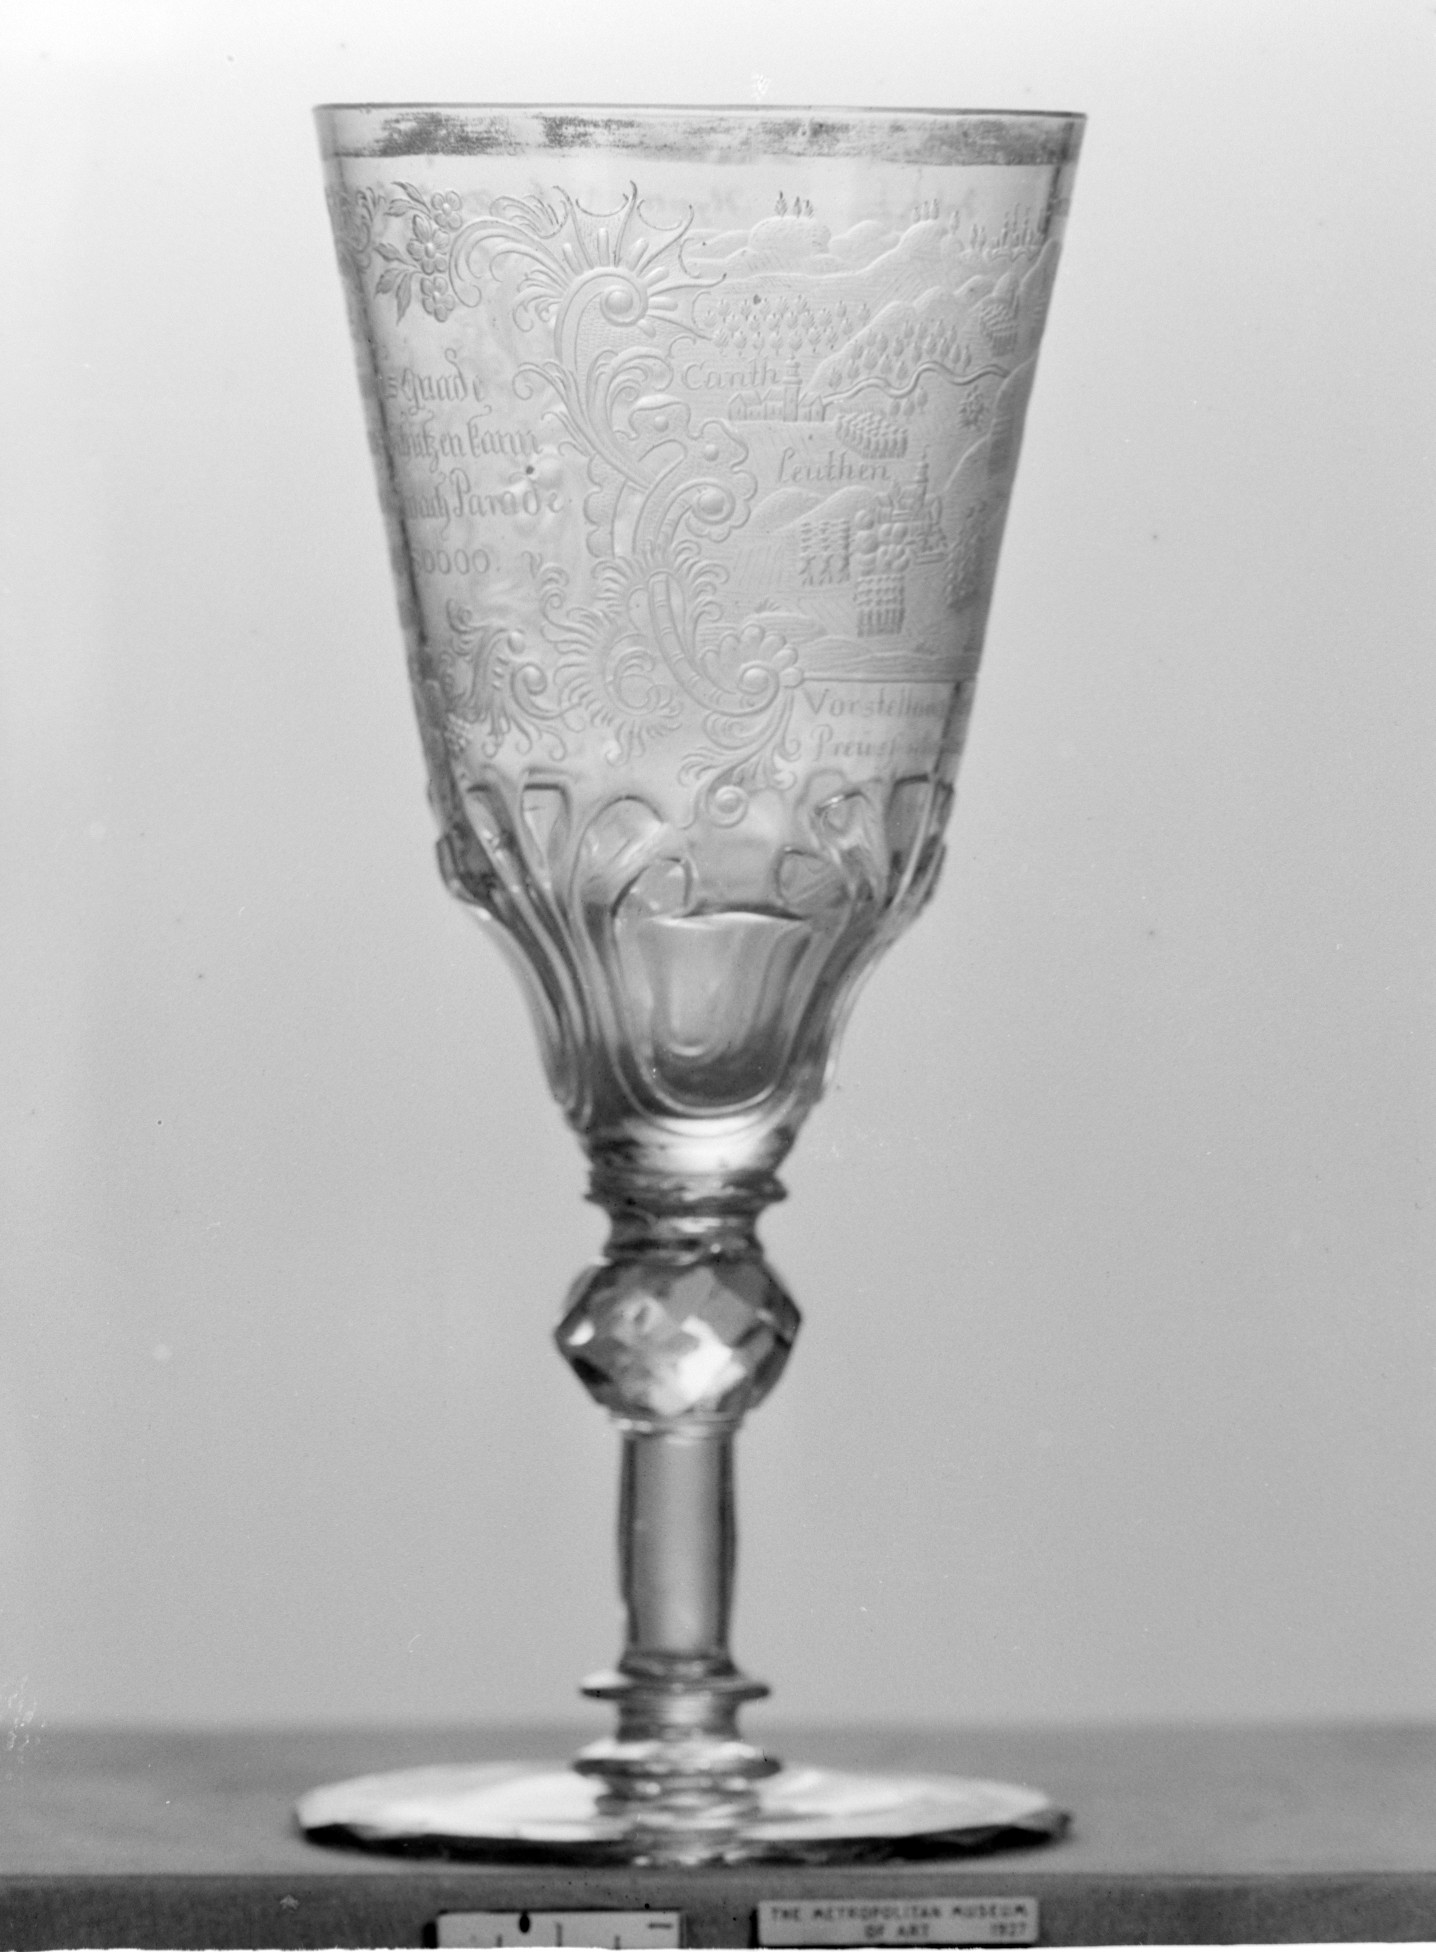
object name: standing cup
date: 1757-1758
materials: glass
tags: flowers